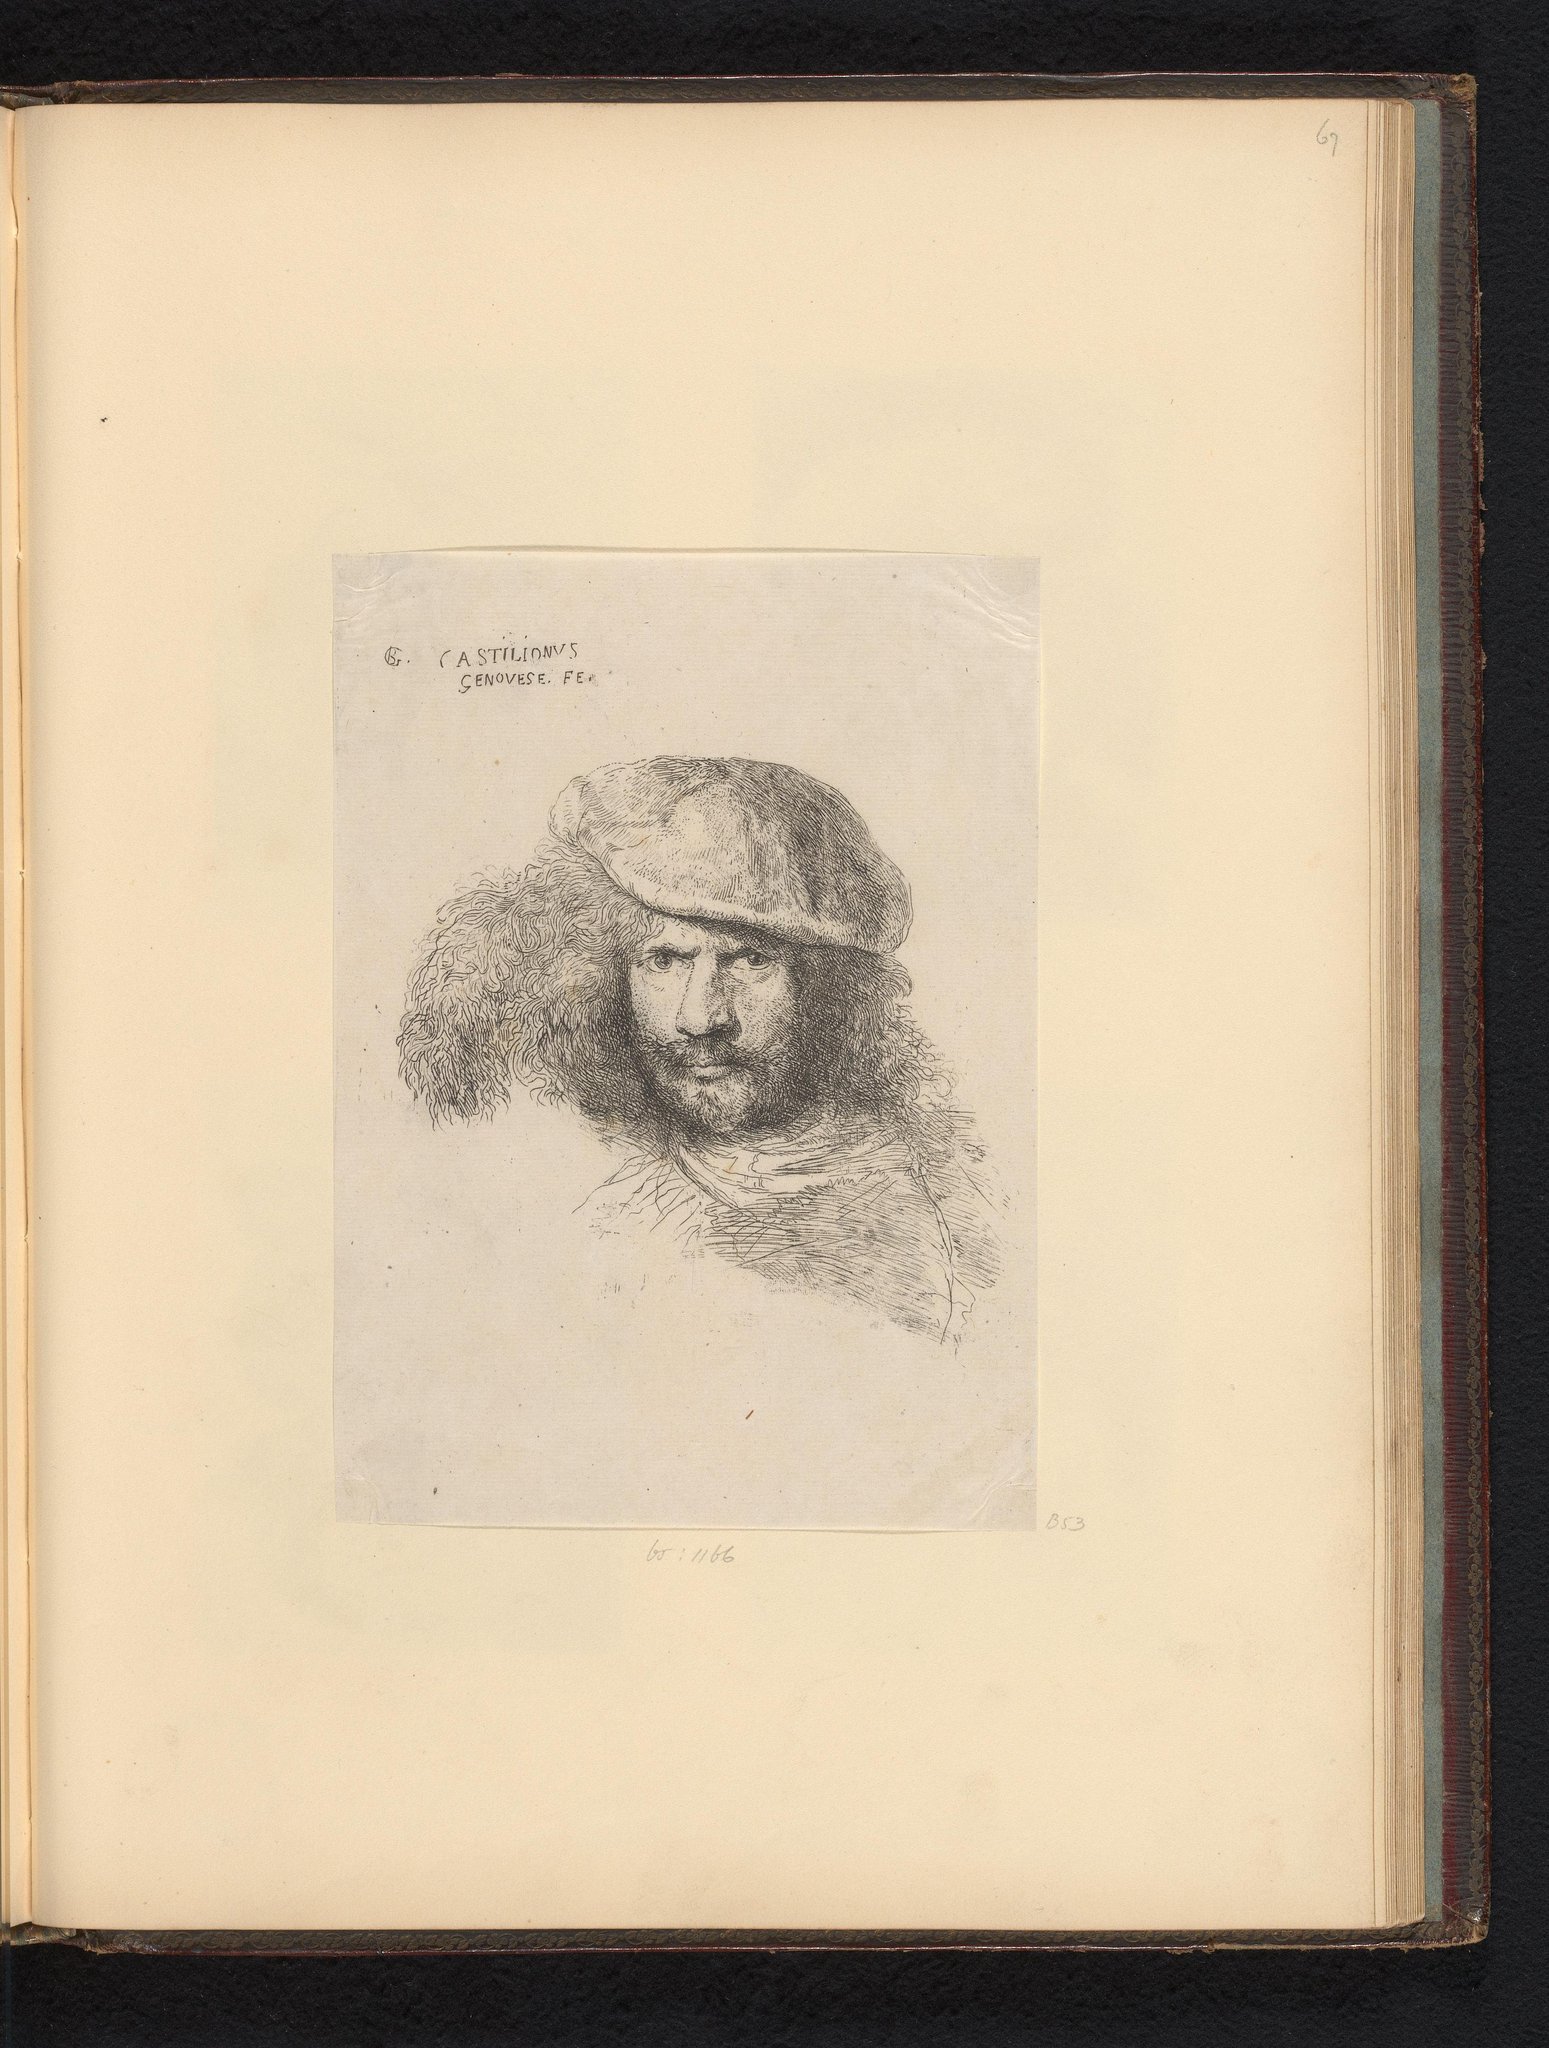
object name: album leaf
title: Grote studie van hoofden met oosterse hoofddeksels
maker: giovanni benedetto castiglione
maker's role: draughtsman, print maker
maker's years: 1610-1665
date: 1645-1650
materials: paper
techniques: etching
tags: naples, rome, painter, sculptor, gian lorenzo bernini, historical persons, portrait, self-portrait of painter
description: Prent uit een serie van zes prenten door Castiglione. Prent maakt mogelijk deel uit van een serie van 200 prenten. Deze serie is onder de titel 'A Collection of two hundred original etchings' voor het eerst uitgegeven door J.M. Greery in 1816.